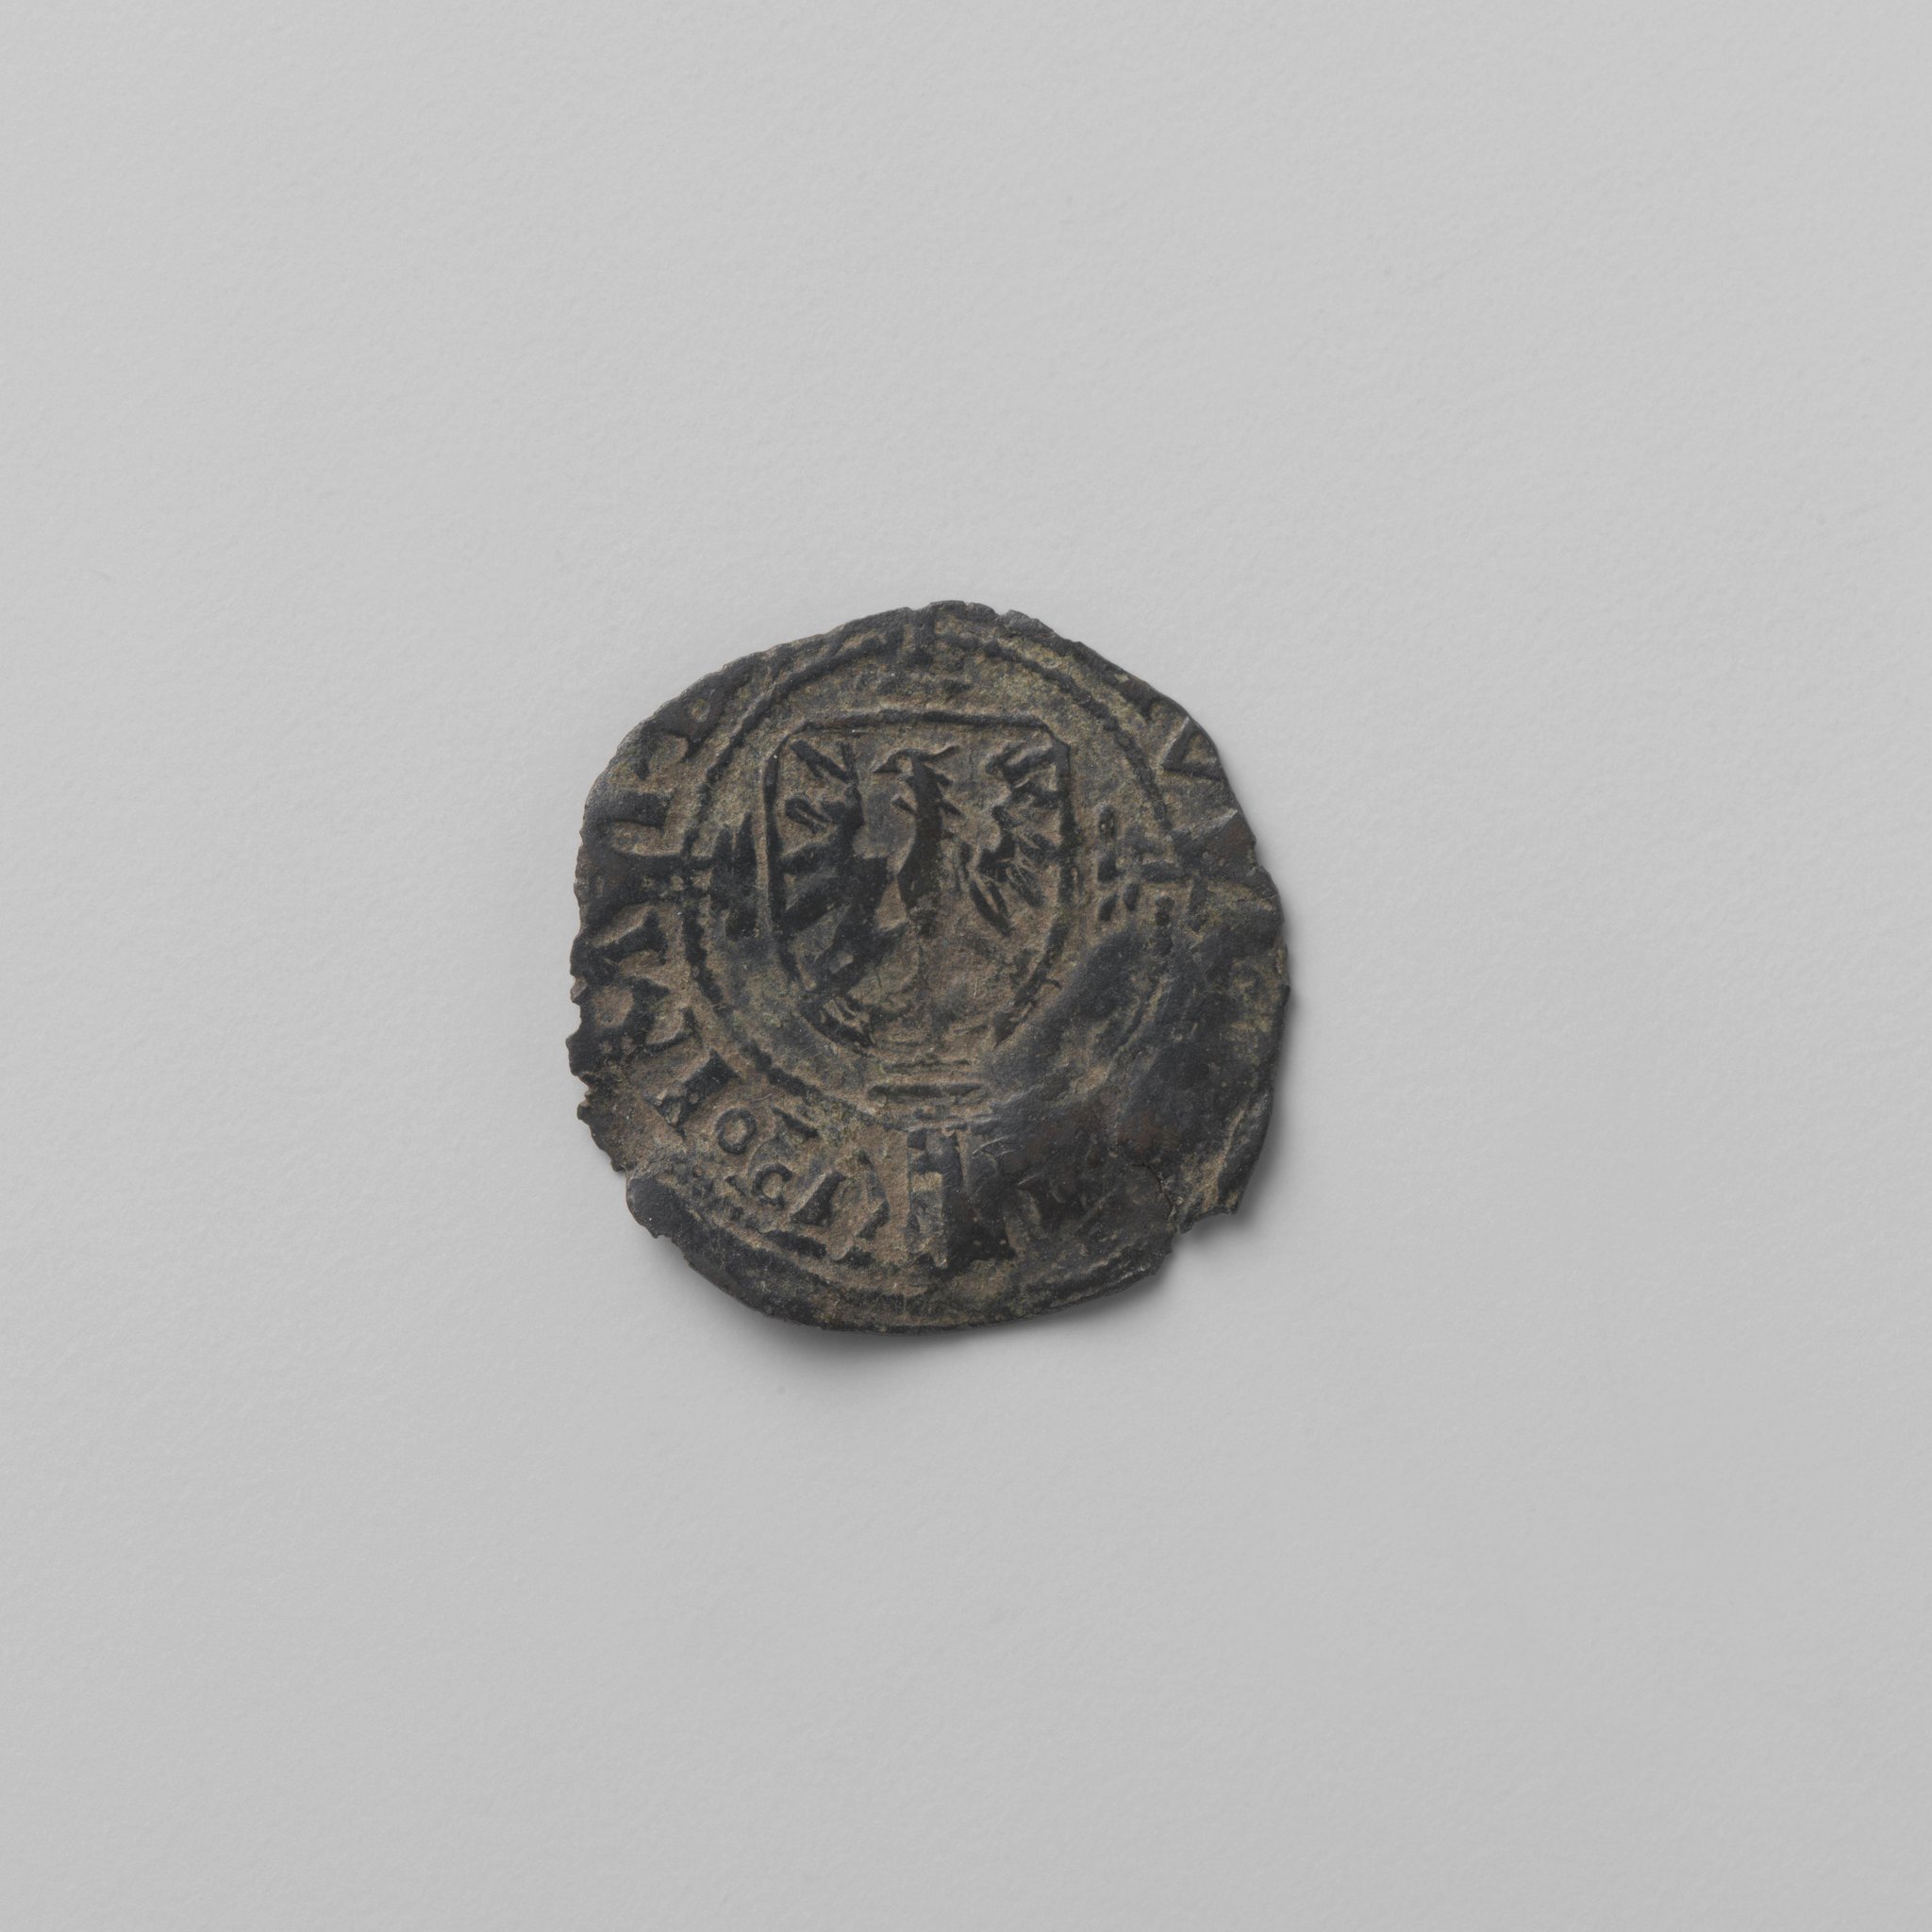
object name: coin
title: Plak van de Drie Steden, 1575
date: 1575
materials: silver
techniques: striking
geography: deventer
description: Koper-zilveren munt. Voorzijde: Wapenschild van Deventer op lang kruis. Jaartal 75 in omschrift. Keerzijde: wapenschildjes van de Drie Steden, in het centrum cijfer I.